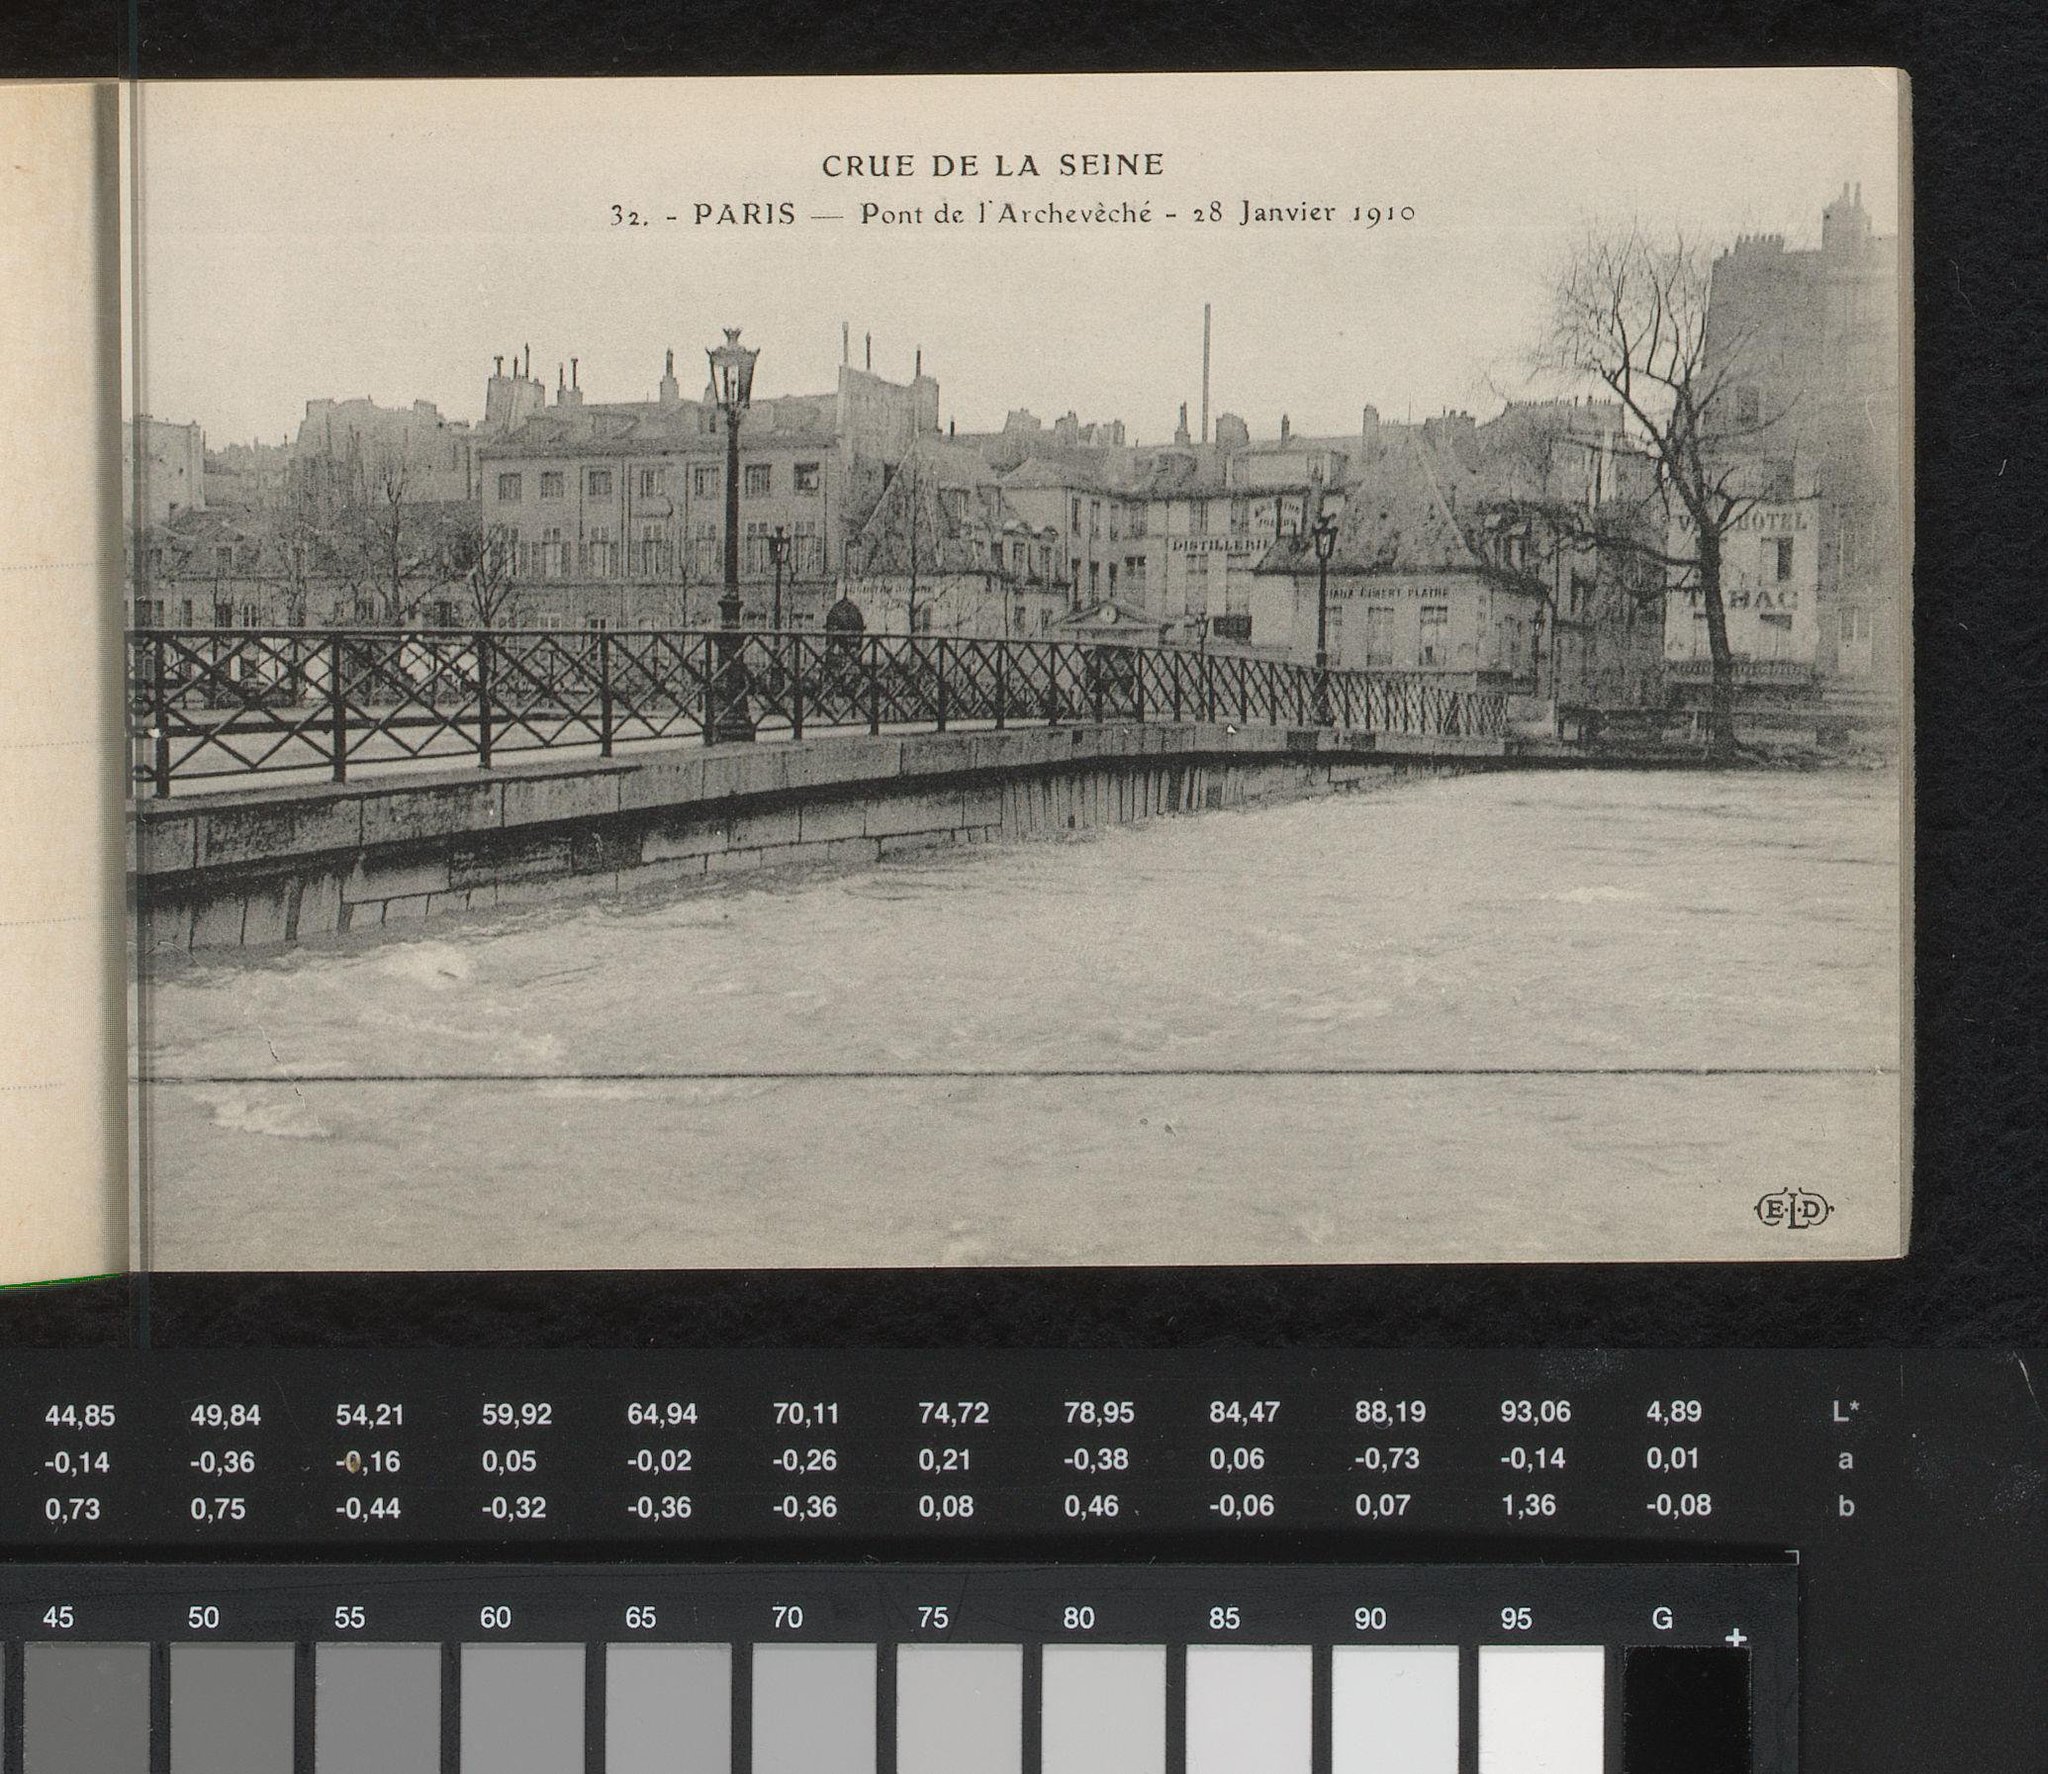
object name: photomechanical print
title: Paris. Pont de l'Archevêché. 28 Janvier 1910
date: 1910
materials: cardboard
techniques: photograph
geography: paris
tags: flood, bridge, city-view, and landscape with man-made constructions (+ city(-scape) with figures, staffage), paris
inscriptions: date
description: Prentbriefkaart maakt deel uit van een album.